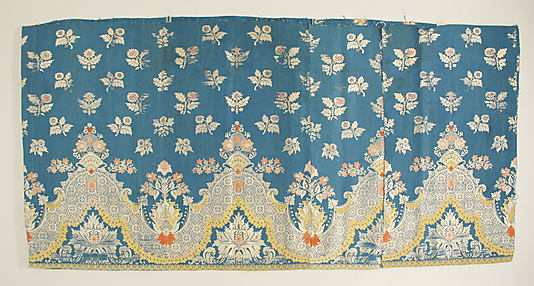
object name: skirt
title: Skirt (in two pieces)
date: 1730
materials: silk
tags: flowers